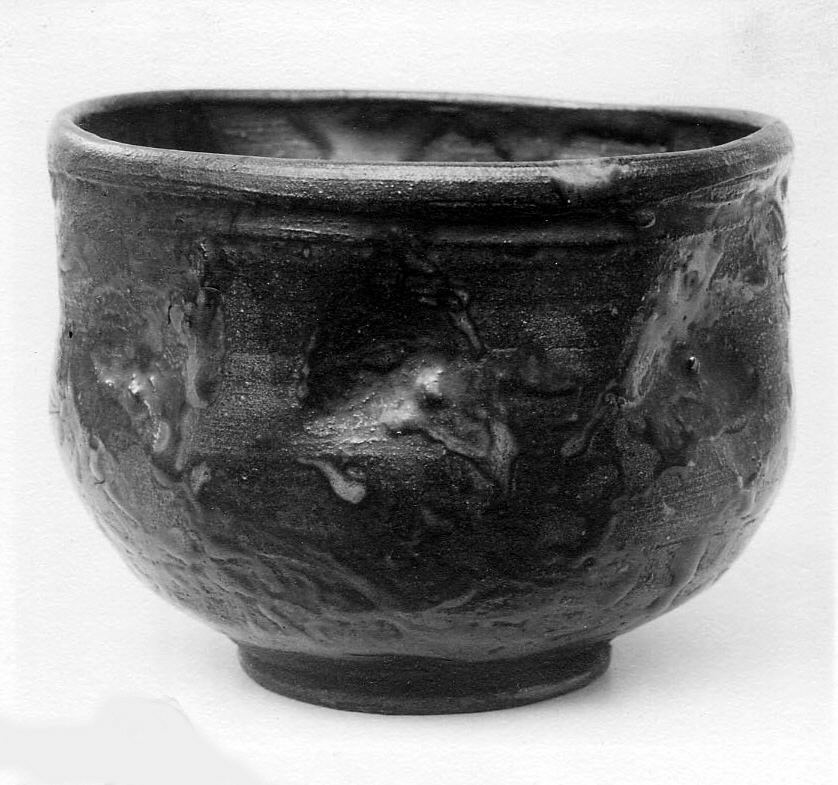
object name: teabowl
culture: japanese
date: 1830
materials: clay, glaze